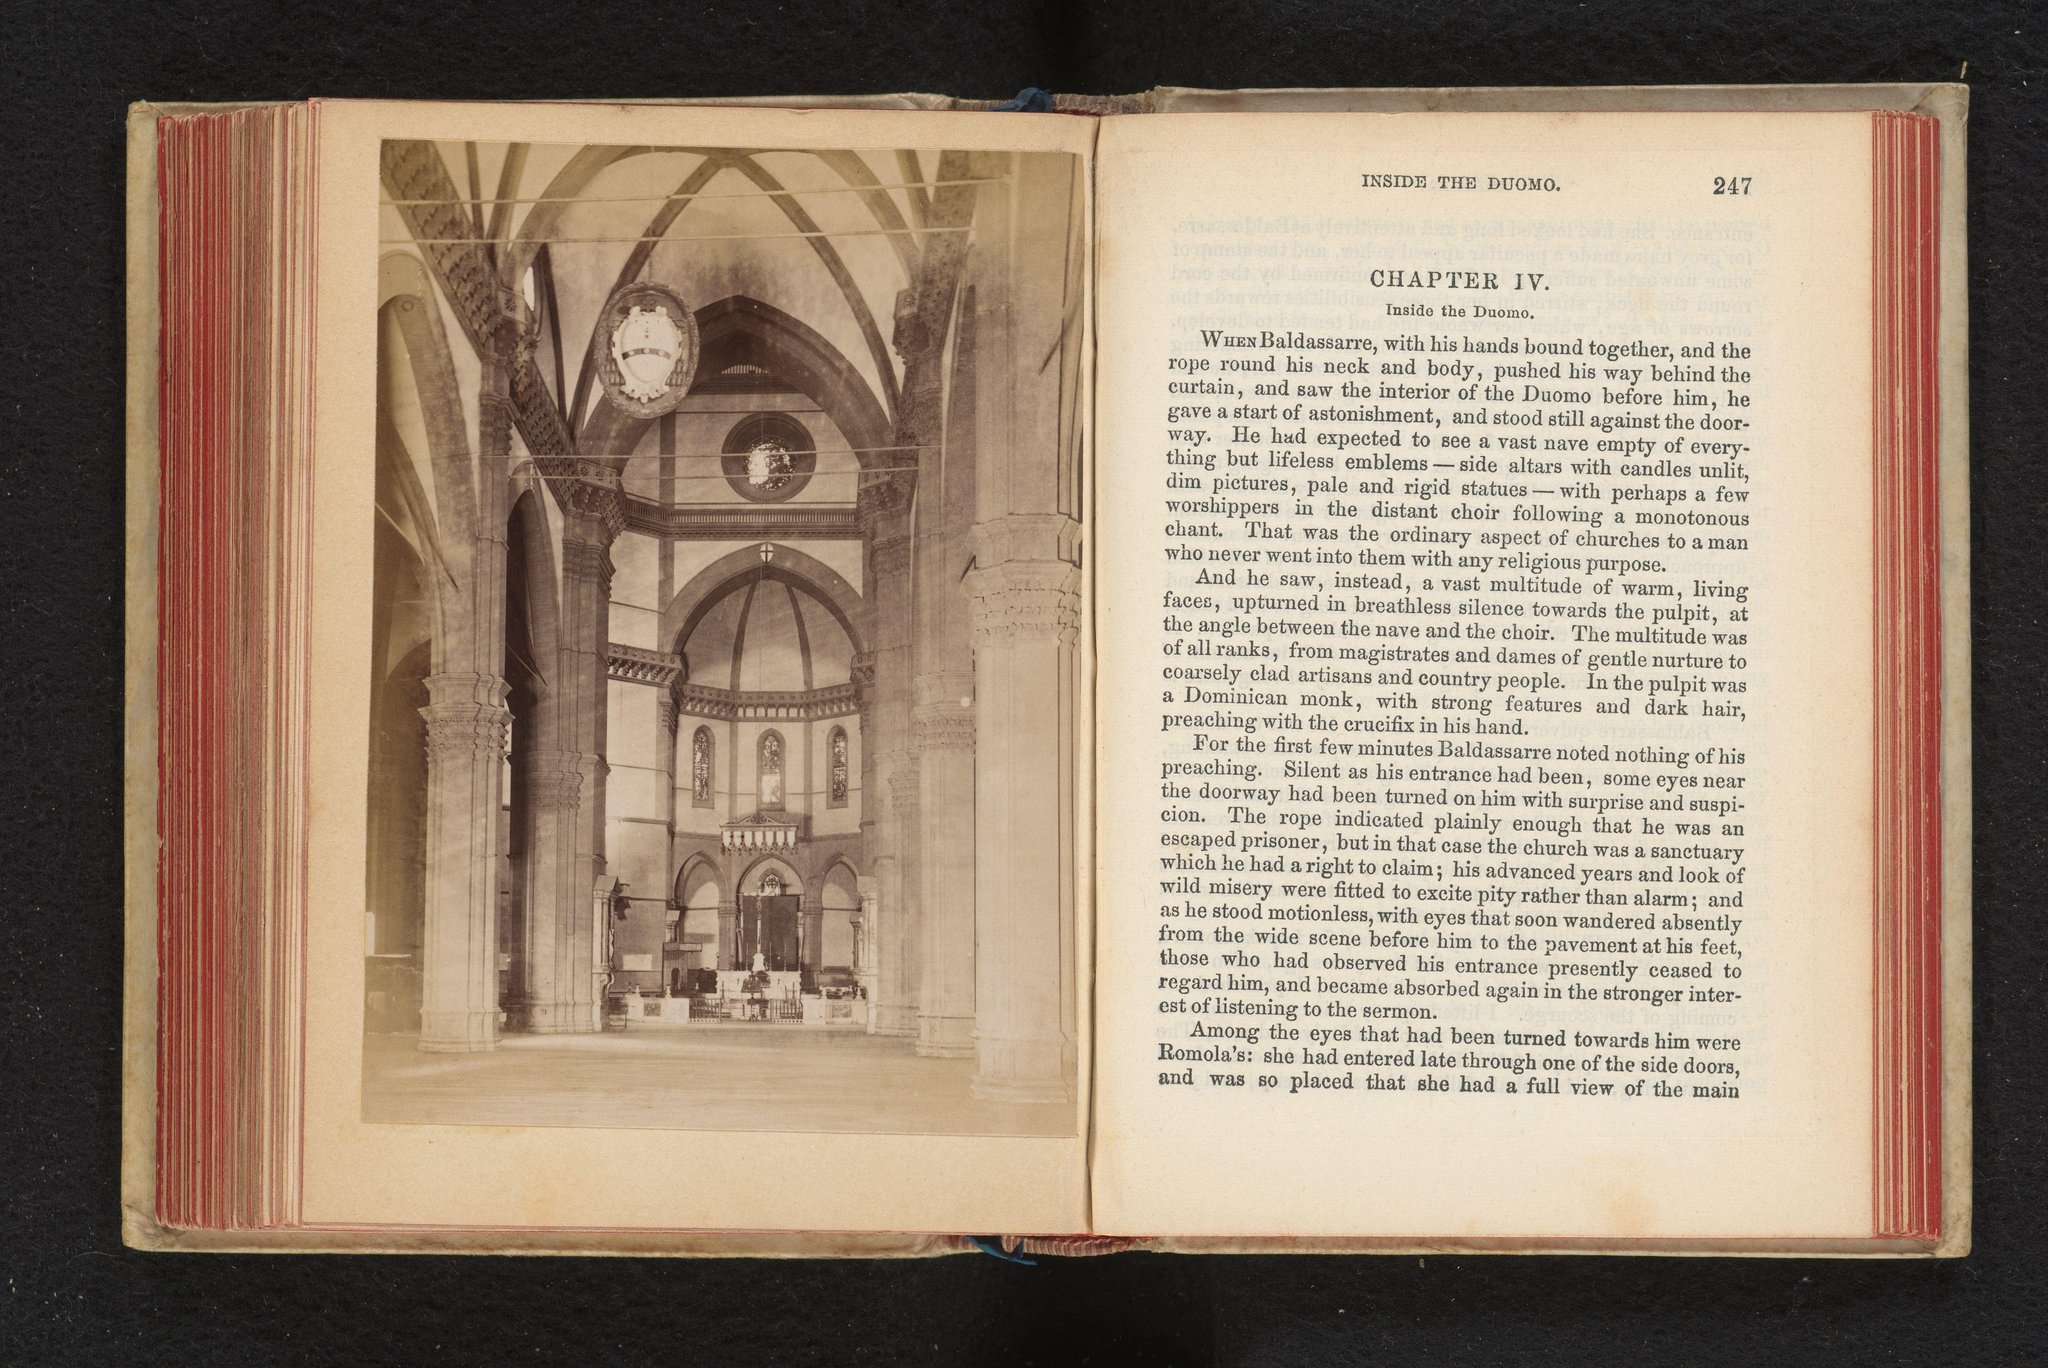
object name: page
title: Interieur van de Dom van Florence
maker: giacomo brogi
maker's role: fotograaf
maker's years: 1822-1881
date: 1858-1863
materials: paper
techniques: albumen print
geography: florence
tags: interior of church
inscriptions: name: ‘Brogi’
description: Foto op ongenummerde pagina tegenover pagina 247.